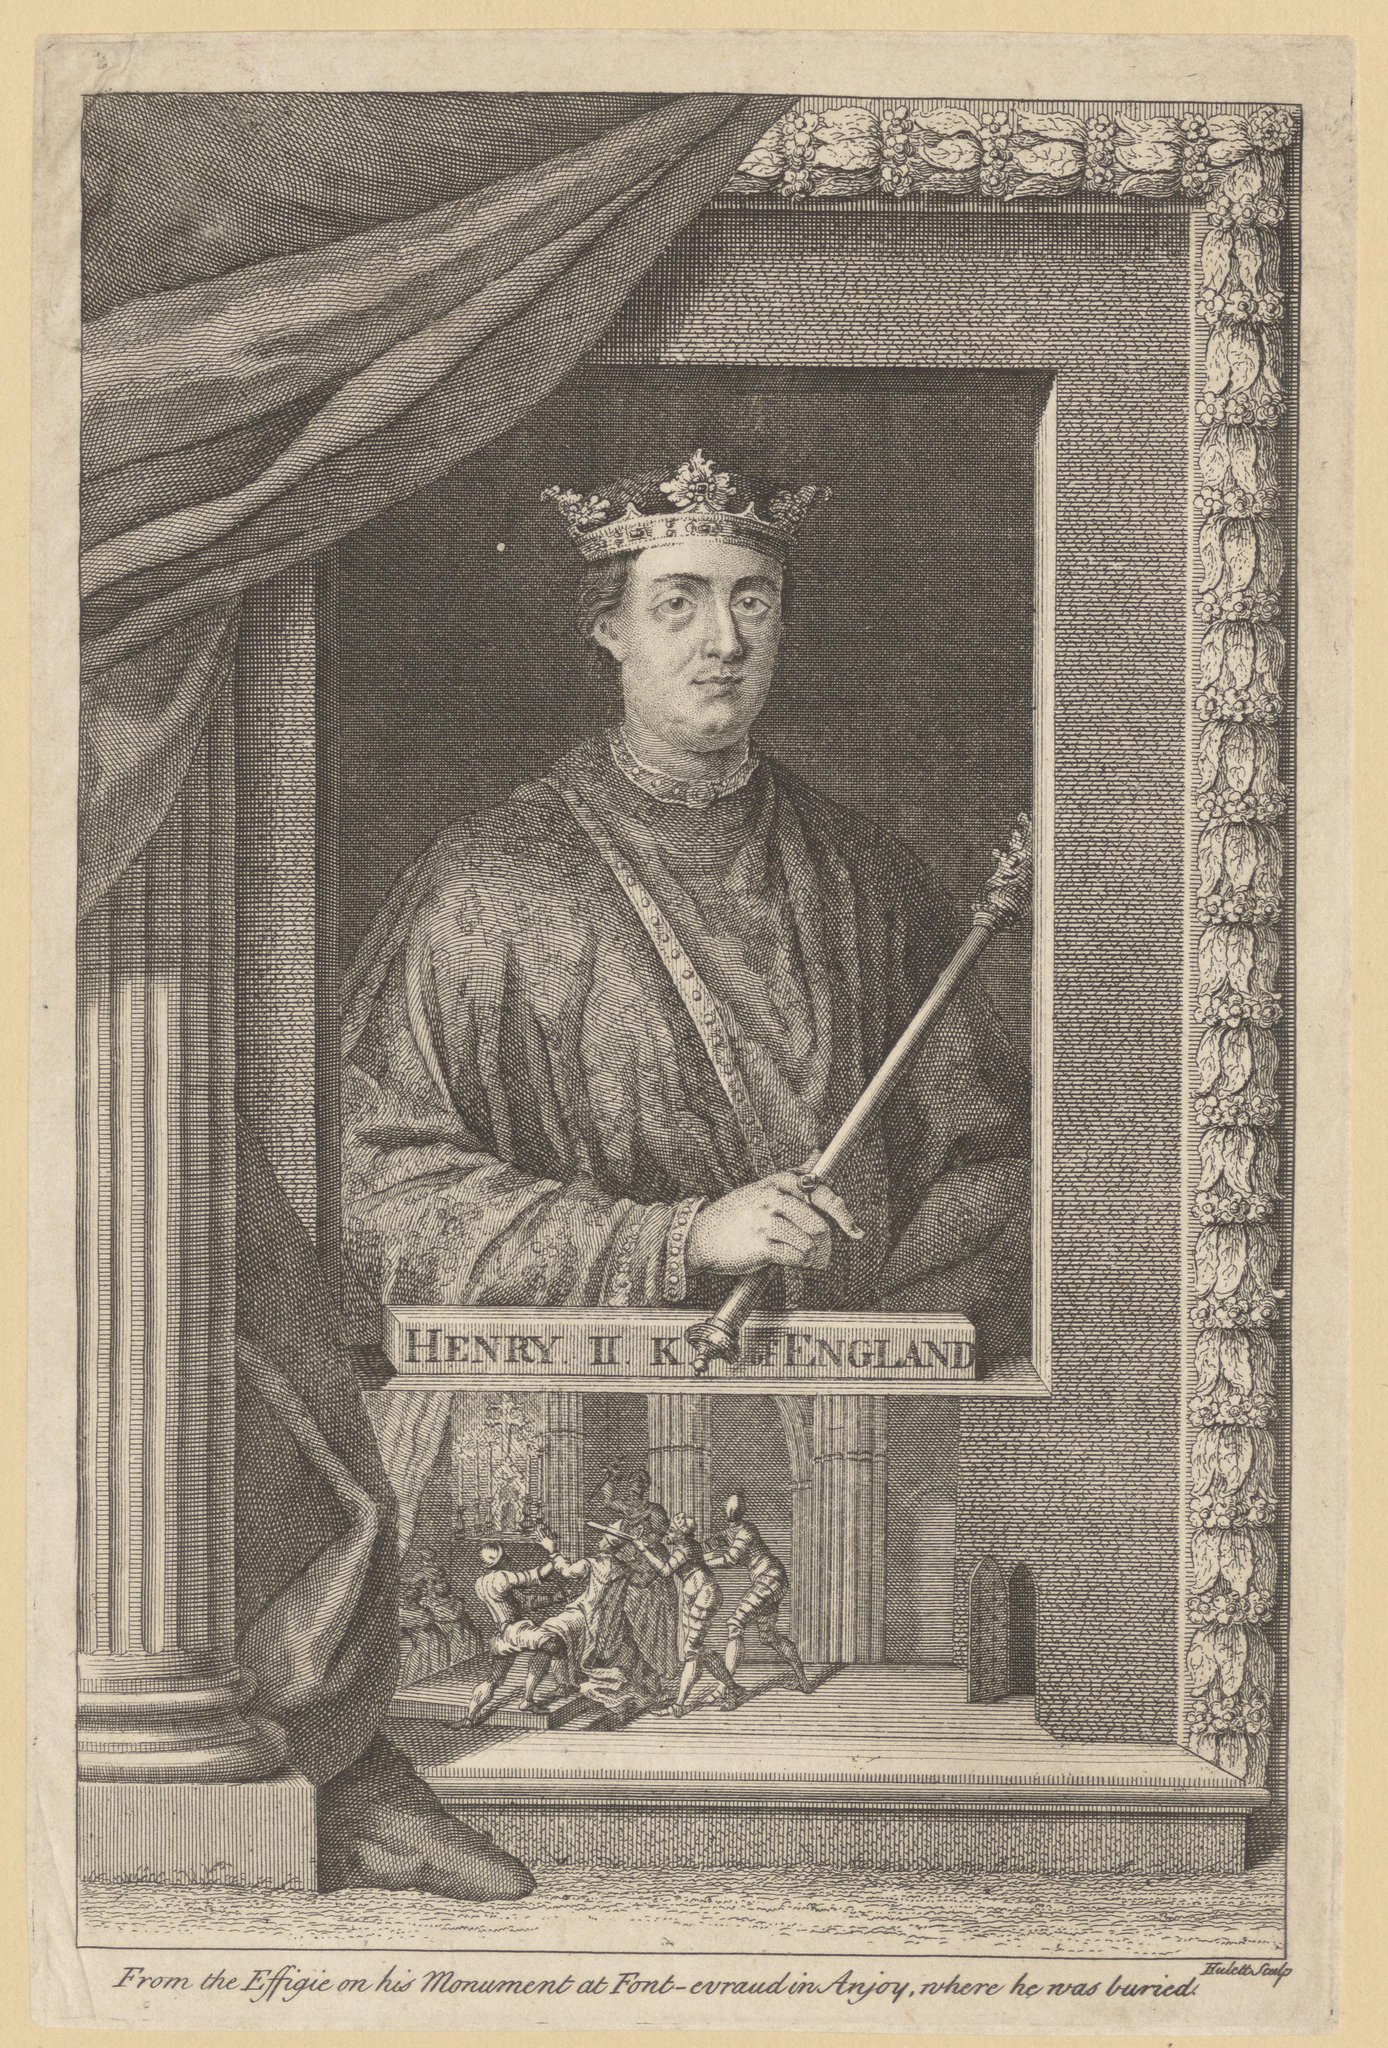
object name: print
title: Portret van Hendrik II, koning van Engeland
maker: james hulett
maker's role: print maker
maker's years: -1771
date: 1671-1771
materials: paper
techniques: engraving, etching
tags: historical persons, king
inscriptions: collector's mark: Lugt 2228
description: Deze prent is gemaakt naar een afbeelding op het graf van Hendrik in de abdij van Fontevraud.